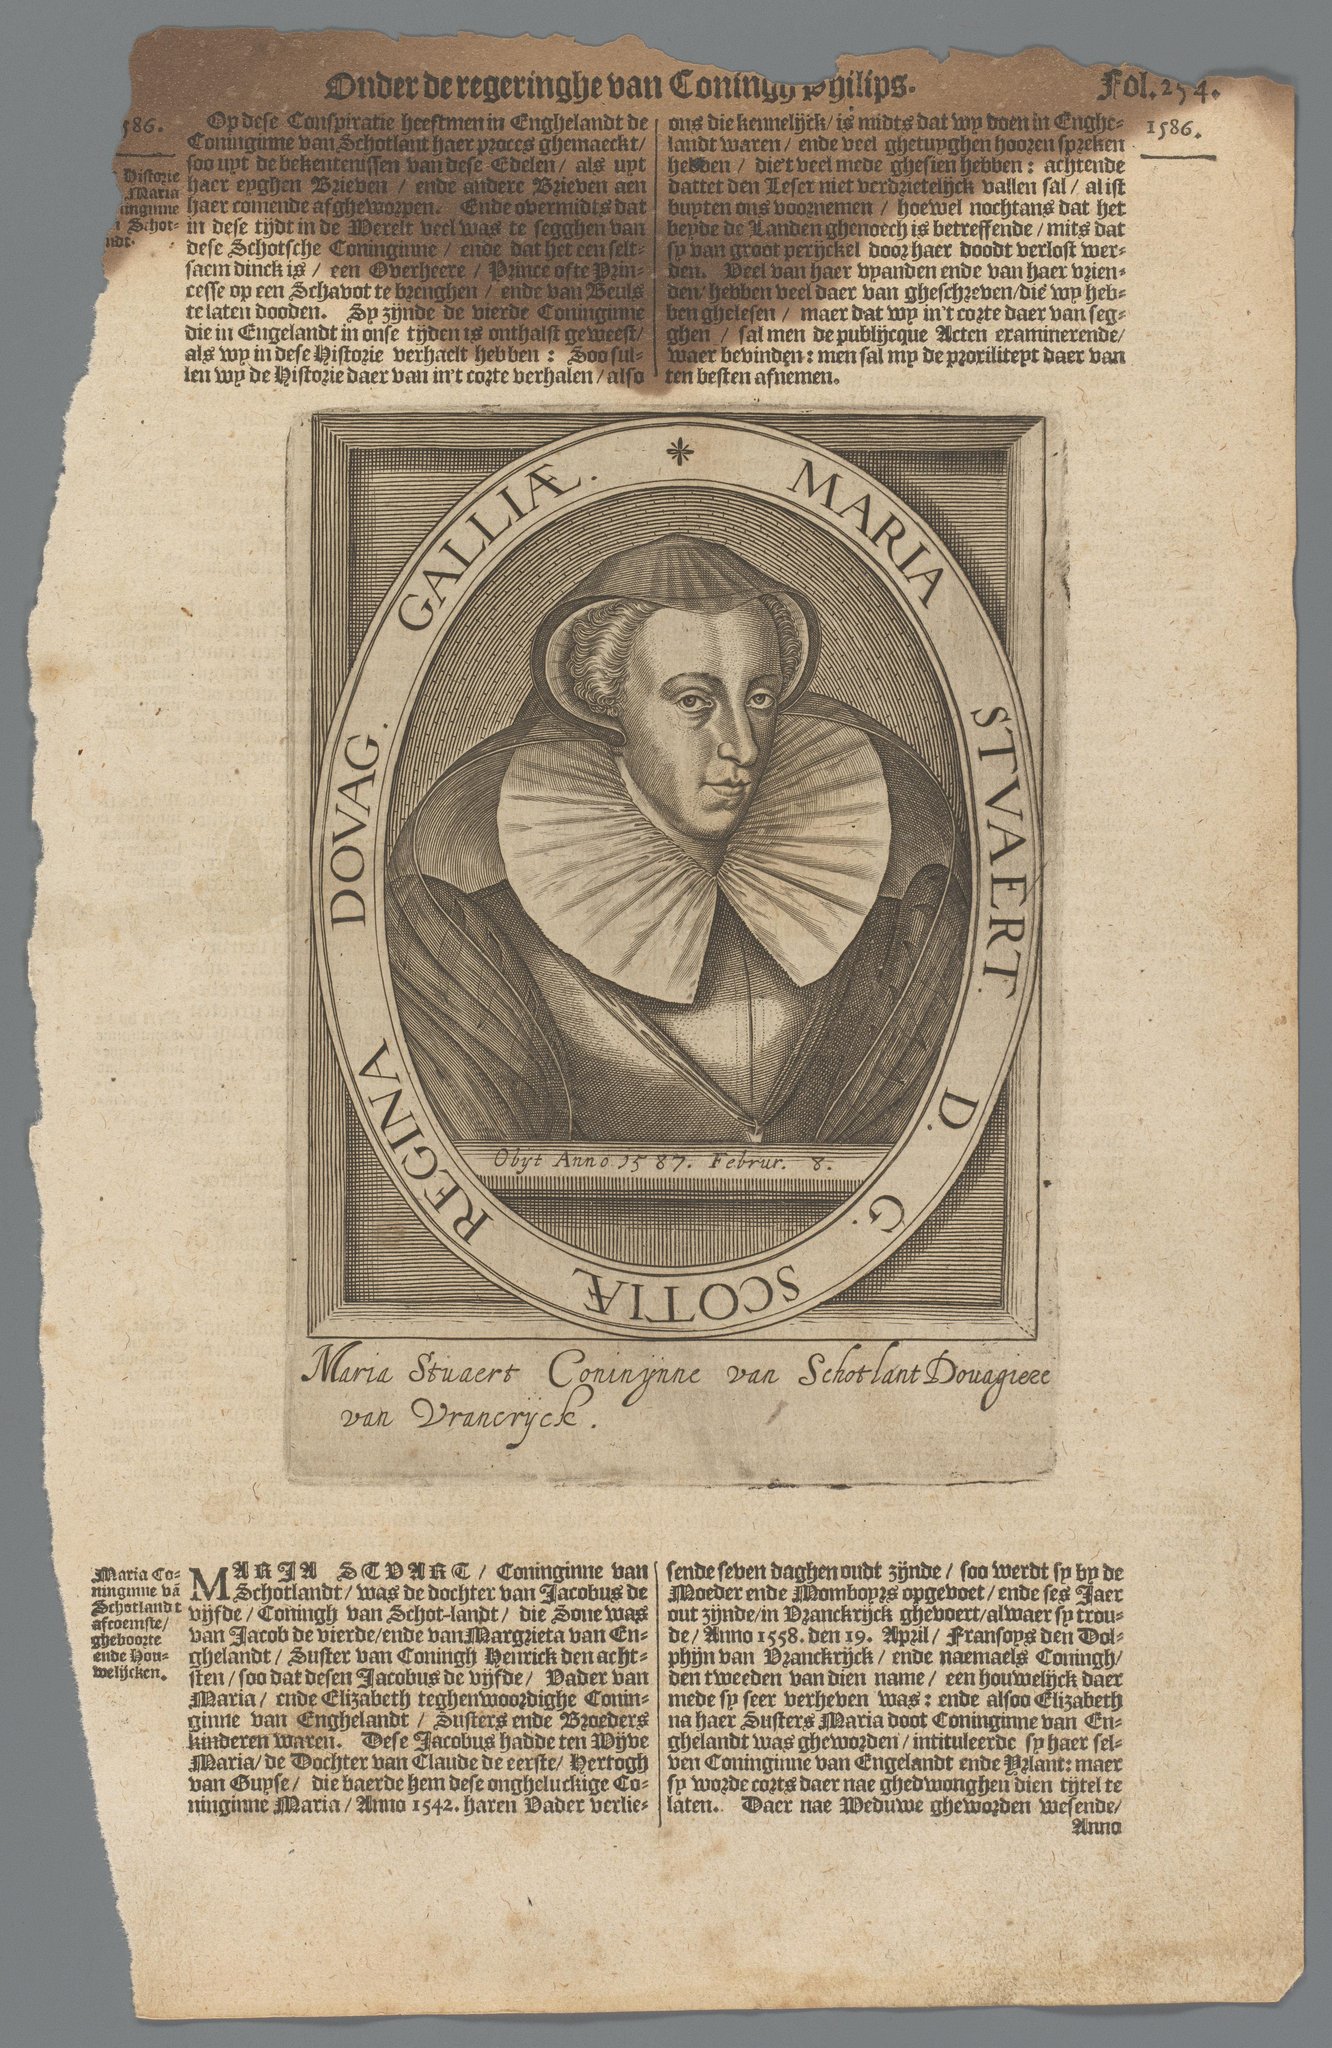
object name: text sheet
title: Maria Stuaert d.g. Scotiae regina dovag. Galliae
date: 1614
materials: paper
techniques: engraving, letterpress printing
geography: the hague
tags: historical persons, queen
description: Prent uit: Meteren, Emanuel van. Historie der Nederlandscher ende haerder na-buren oorlogen ende geschiedenissen (...). Den Haag: Hillebrant Iacobsz. van Wouw, 1614.